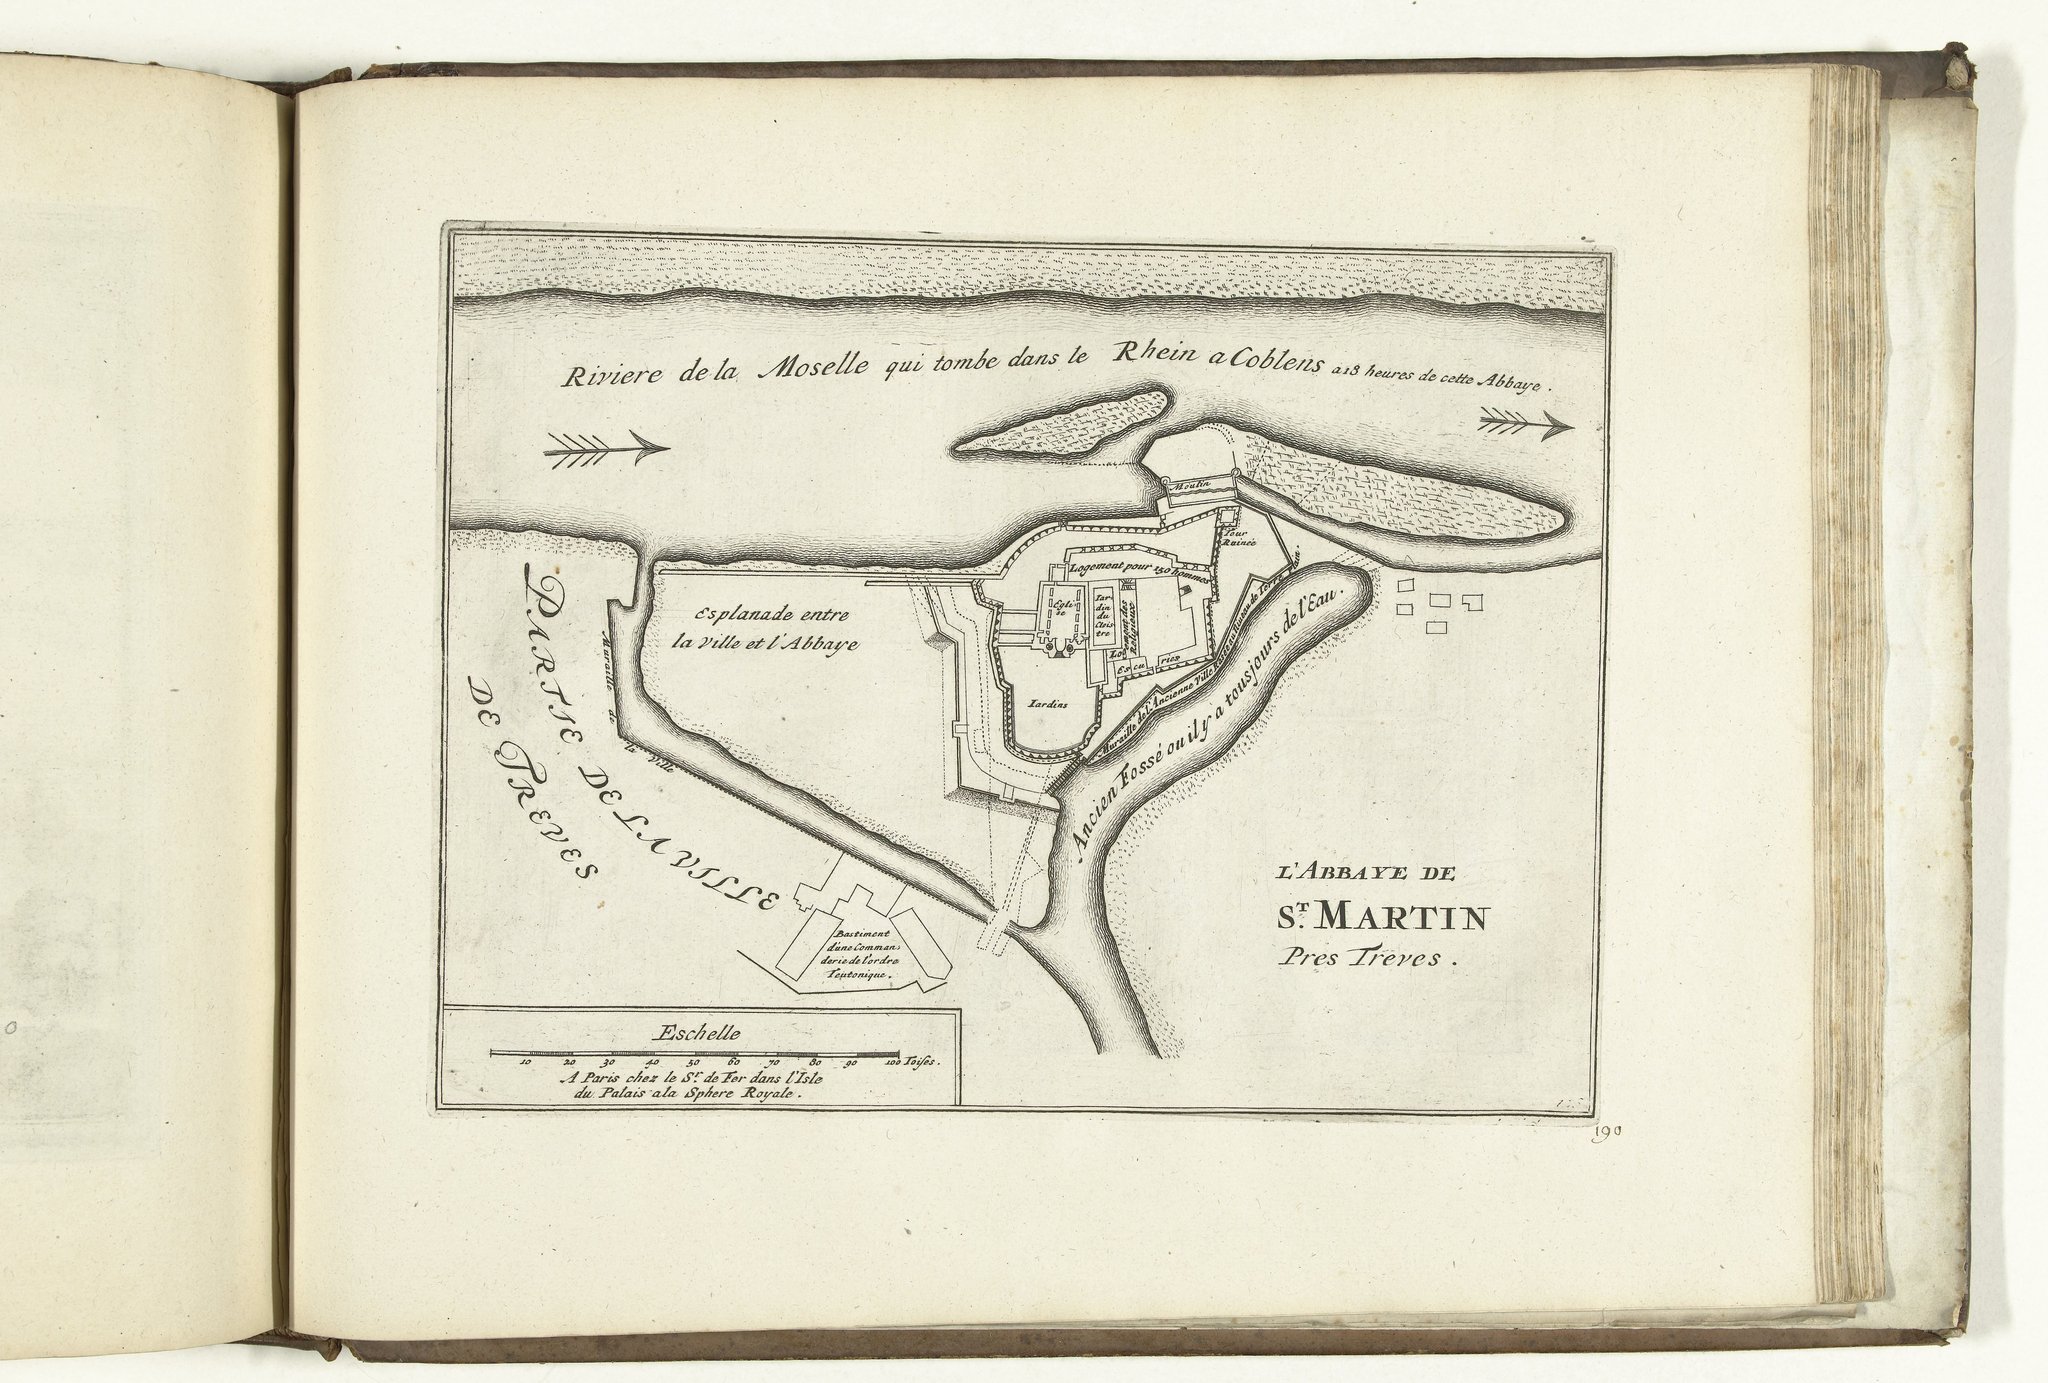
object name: print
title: L'Abbaye de St. Martin Pres Treves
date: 1726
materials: paper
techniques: etching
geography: northern netherlands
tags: fortress, maps of cities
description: Plattegrond van de abdij van St. Martin bij Trier aan de Mosel. Plaat nr. 190 in deel VIII van het prentwerk: Les Forces de l'Europe, Asie, Afrique et Amerique ... Comme aussi les Cartes des Côtes de France et d'Espagne uit 1726, dit eerste deel met 238 met de hand genummerde platen van vermaarde sterke steden en vestingen in het kader van de Spaanse Successieoorlog 1701-1713. Voor het merendeel zijn deze platen gekopieerd naar de anonieme Franse platen van vermaarde sterke steden en vestingen: in Les forces de l'Europe en in: Le theatre de la guerre, dans les Pays-Bas, beide oorspronkelijk uitgegeven door Nicolas de Fer te Parijs (1693-1697) in het kader van de Negenjarige Oorlog. Titel en opschriften in het Frans. Rechtsonder sporen van het weggepolijste nummer: 126.